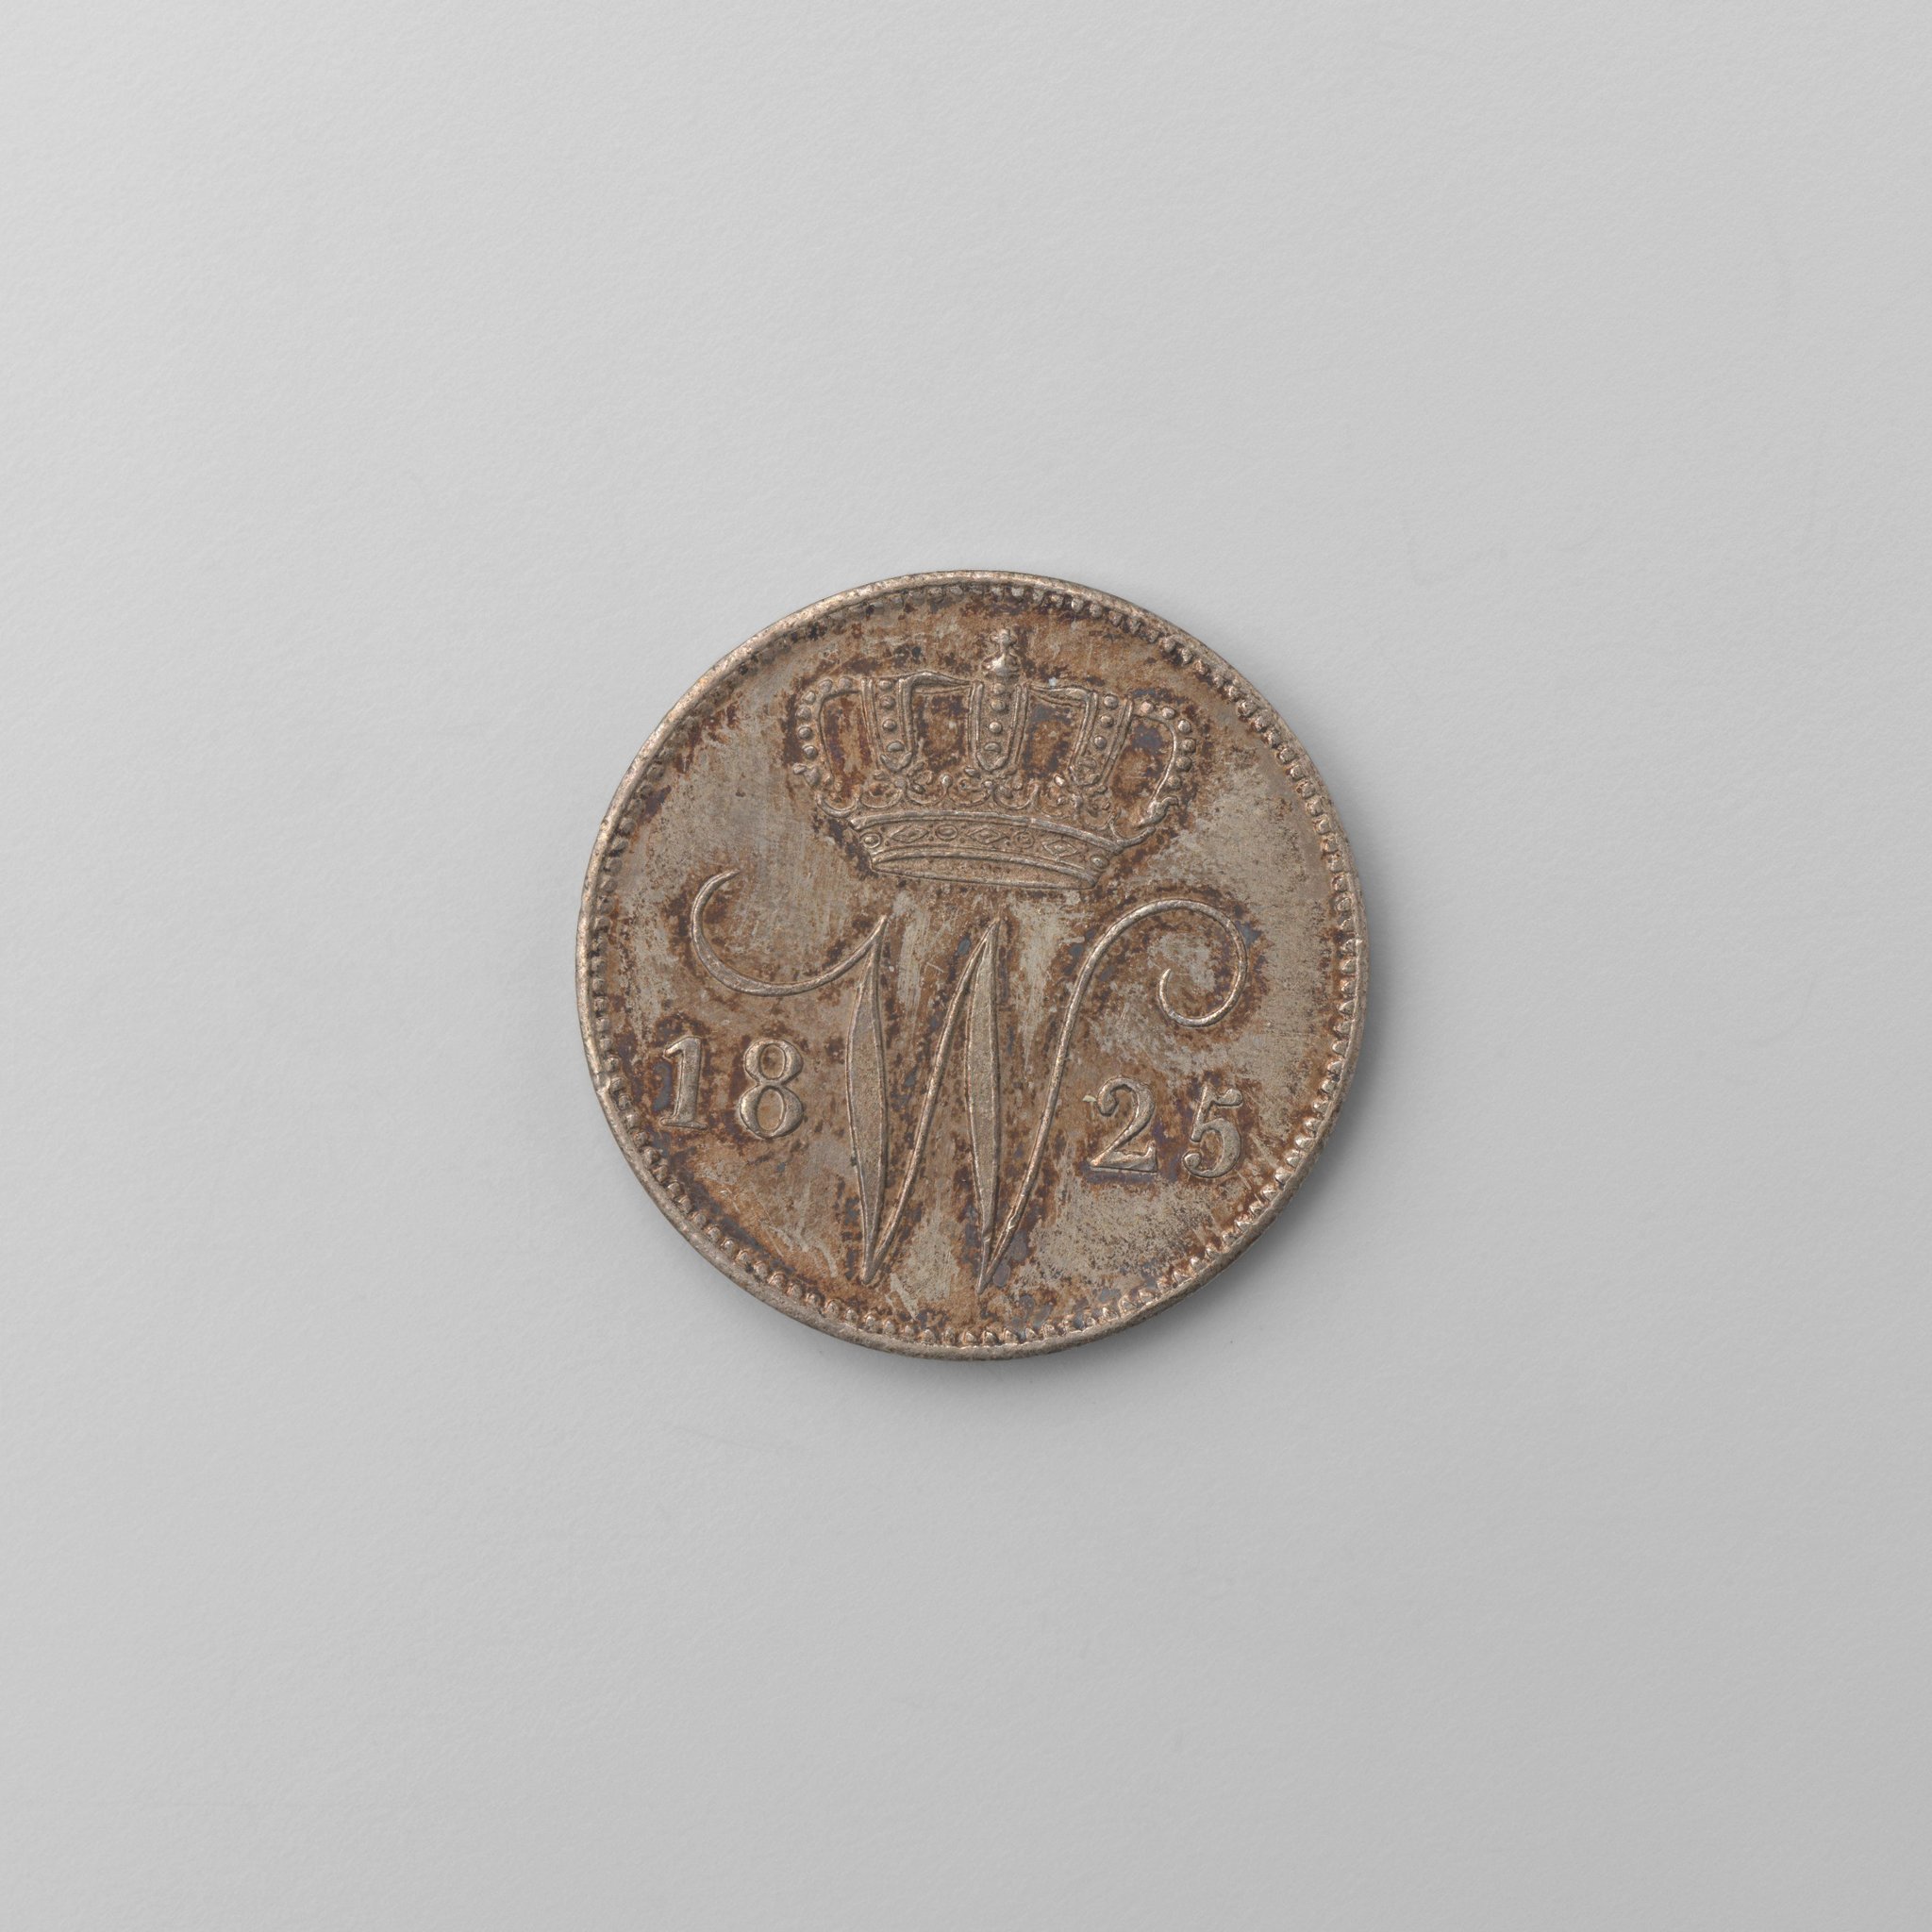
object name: vijfentwintig cent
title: Nederland, 25 cent, 1825 Utrecht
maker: william i of the netherlands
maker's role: koning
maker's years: 1772-1843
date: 1825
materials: silver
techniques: striking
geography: utrecht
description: Zilveren munt. Voorzijde: tussen jaartal gekroonde cursieve letter W. Keerzijde: tussen waarde-aanduiding 25 C. gekroond rijkswapenschild. Gladde rand.